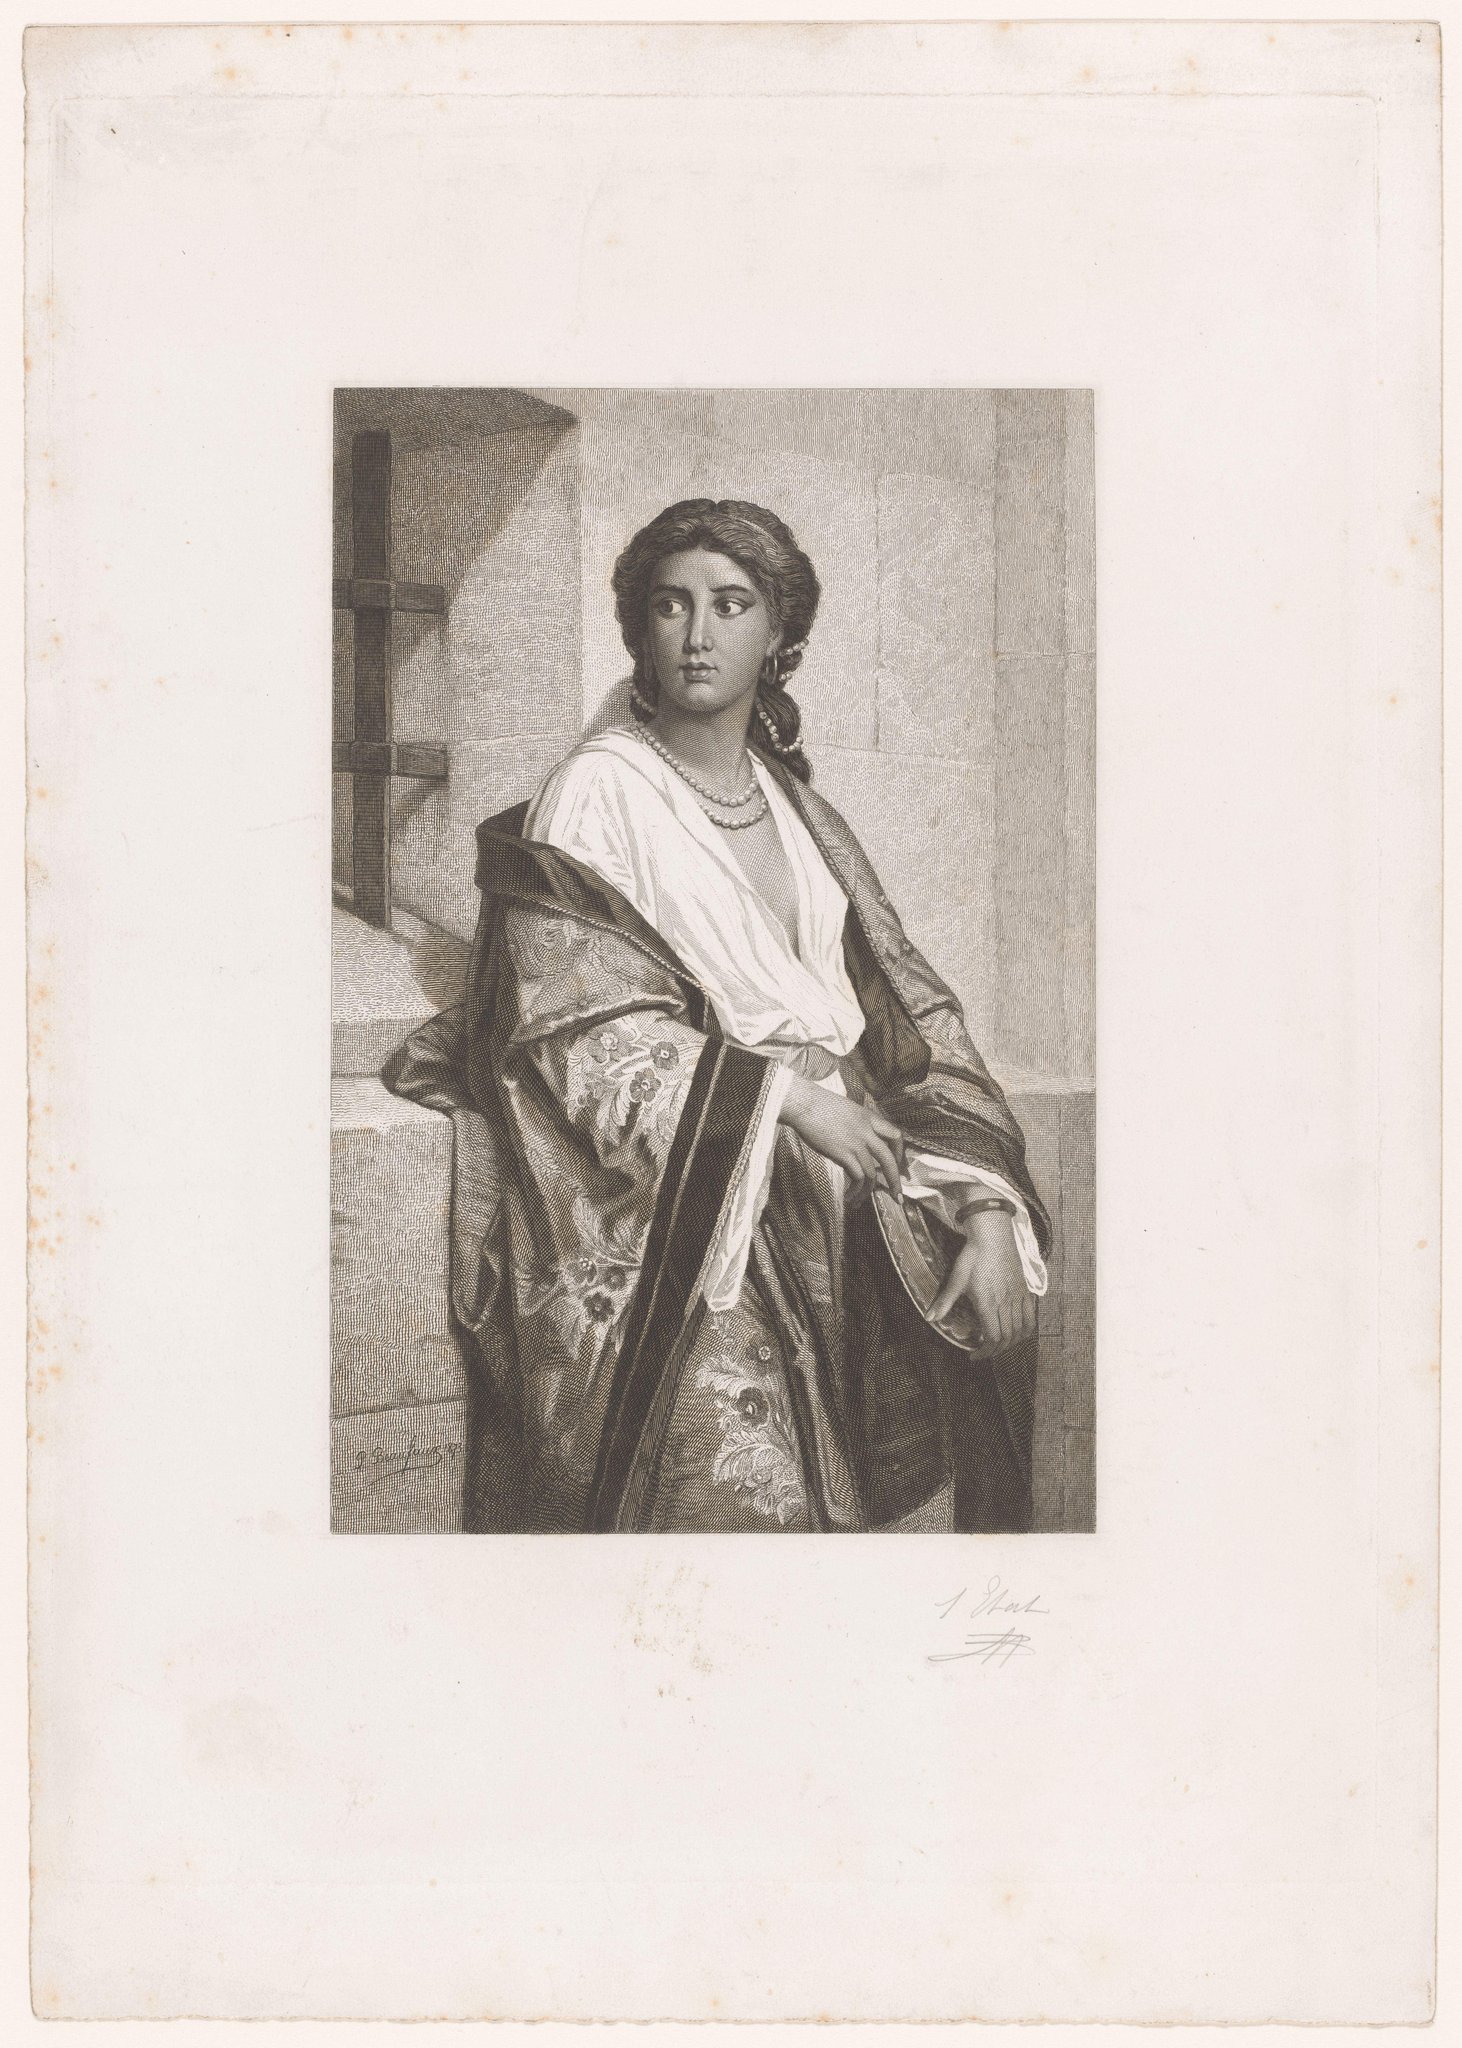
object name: print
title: Salome bespiedt de onthoofding van Johannes de Doper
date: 1873-1890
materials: paper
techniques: engraving, etching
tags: salome (not in biblical context), dish, plate, saucer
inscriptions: collector's mark: Lugt 2228, inscription: ‘1e Etat’